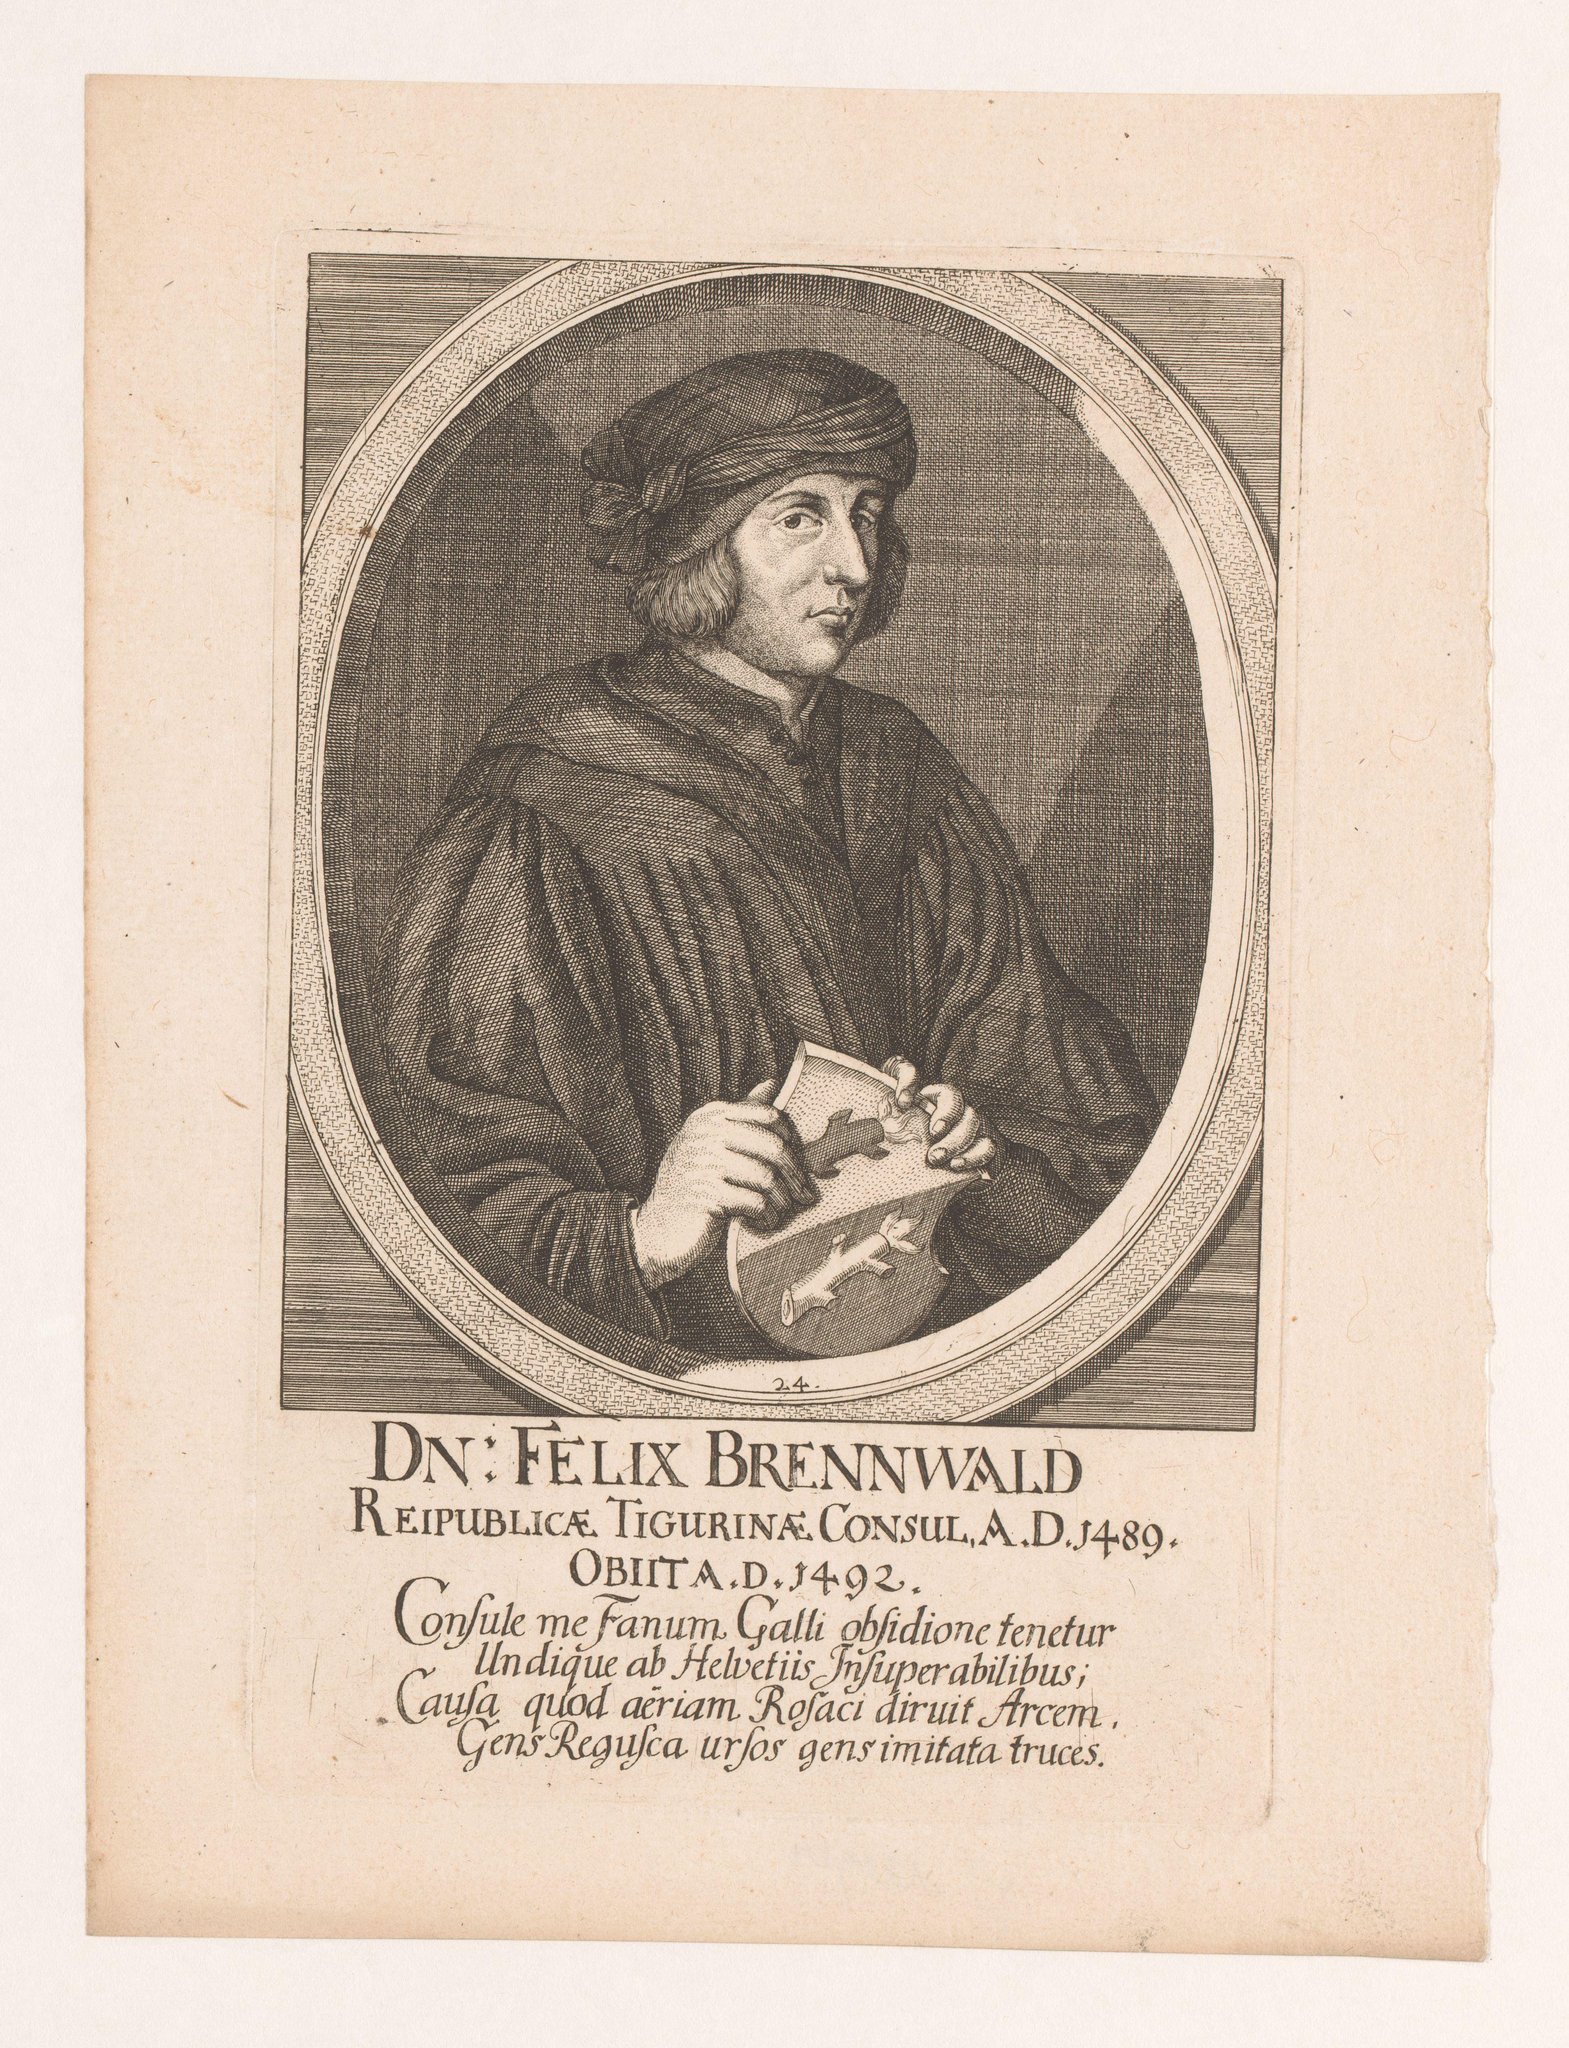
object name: print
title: Portret van Felix Brennwald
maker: johannes meyer (ii)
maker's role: print maker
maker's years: 1655-1712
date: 1665-1712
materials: paper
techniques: engraving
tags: historical persons, armorial bearing, heraldry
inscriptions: collector's mark: Lugt 2228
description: Onderaan de ovale omlijsting genummerd: 24.